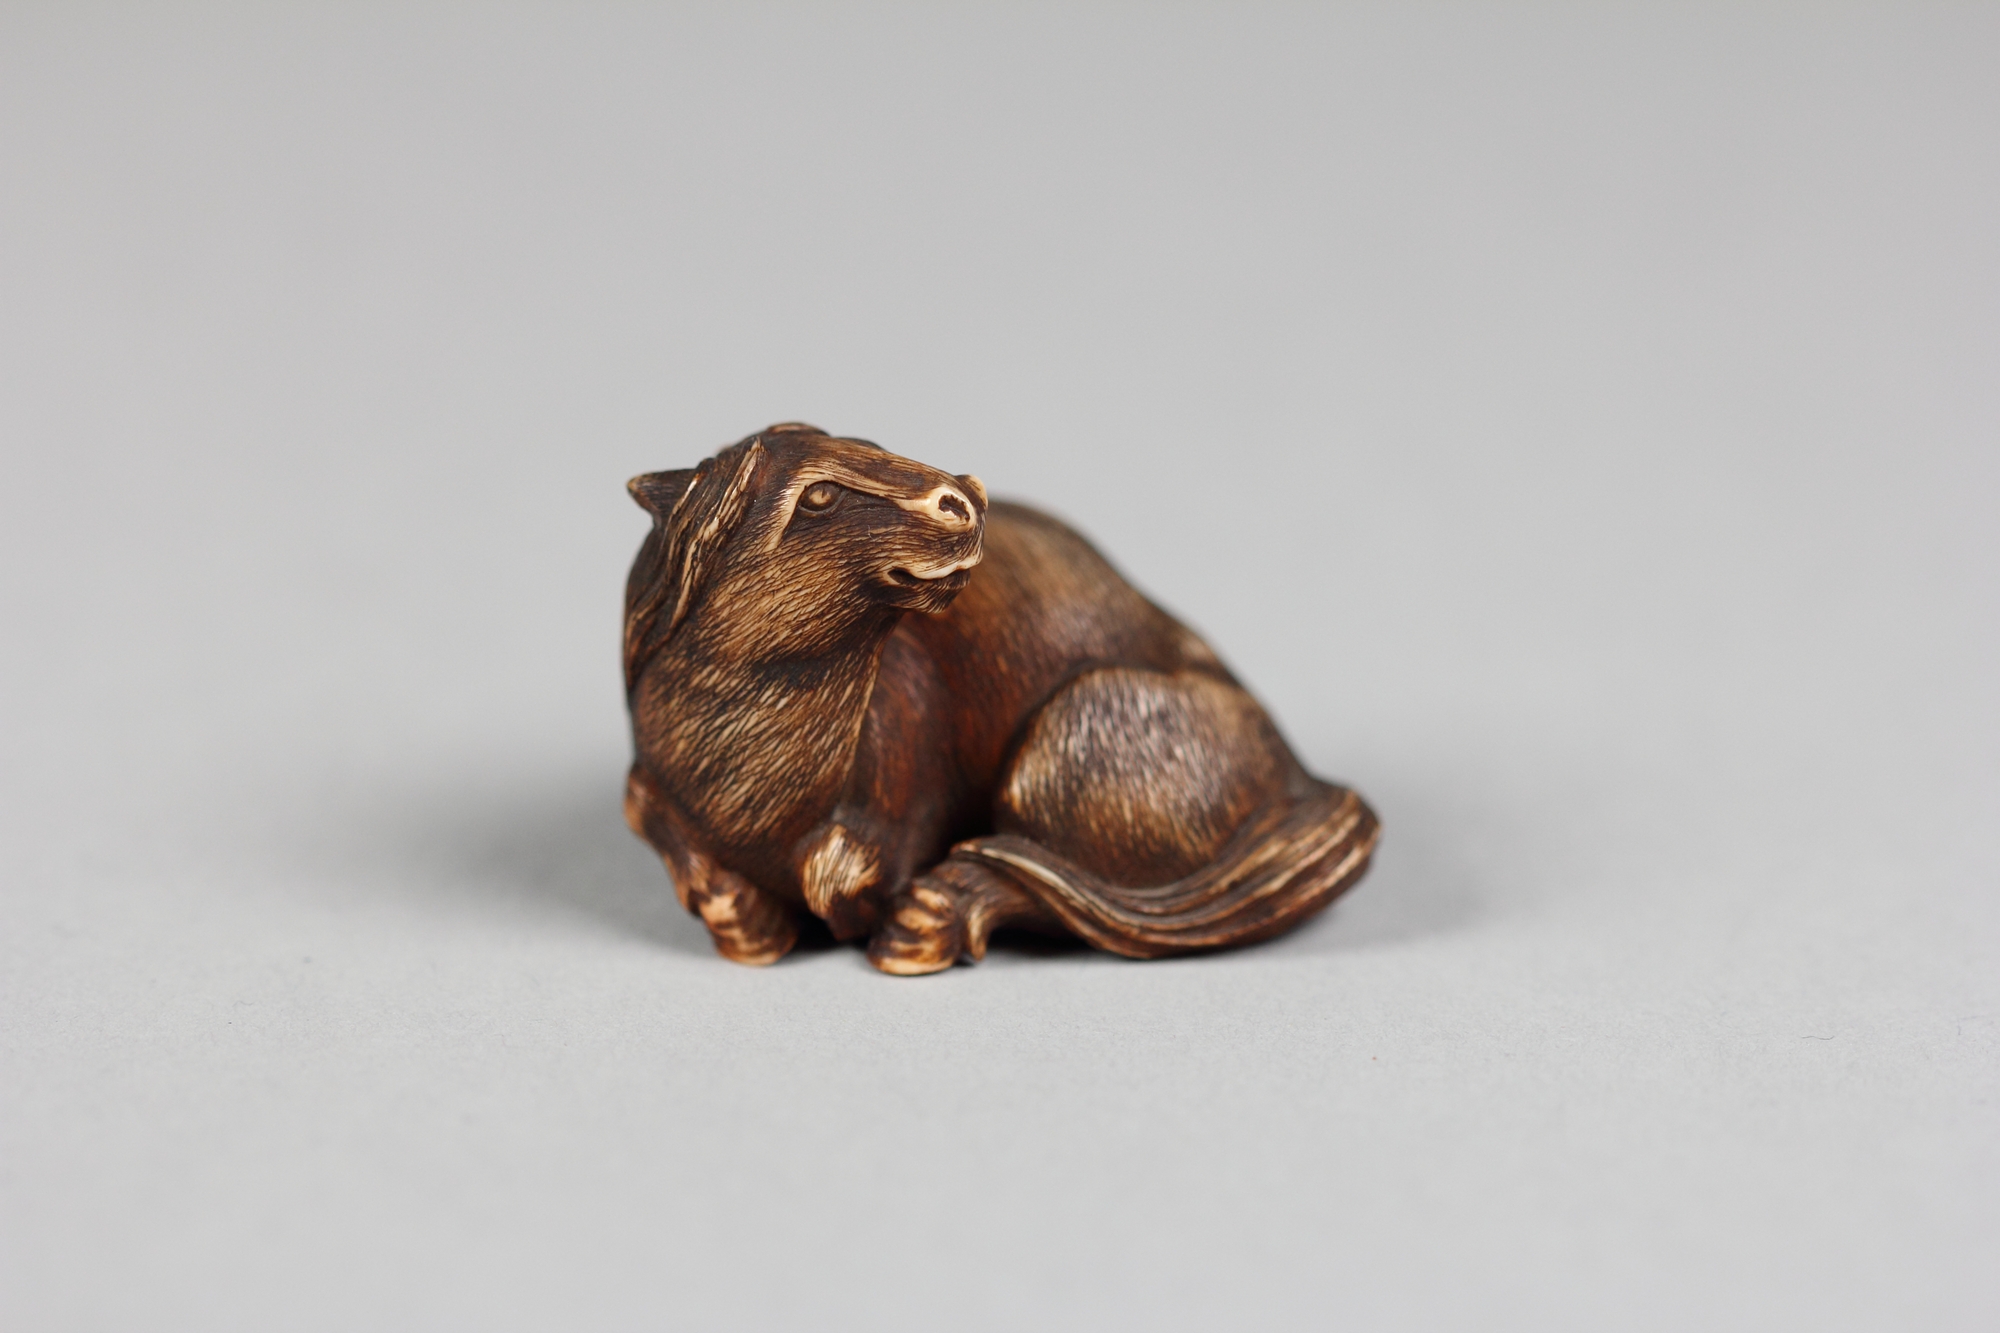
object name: netsuke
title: Horse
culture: japanese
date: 1801-1900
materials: ivory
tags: horses